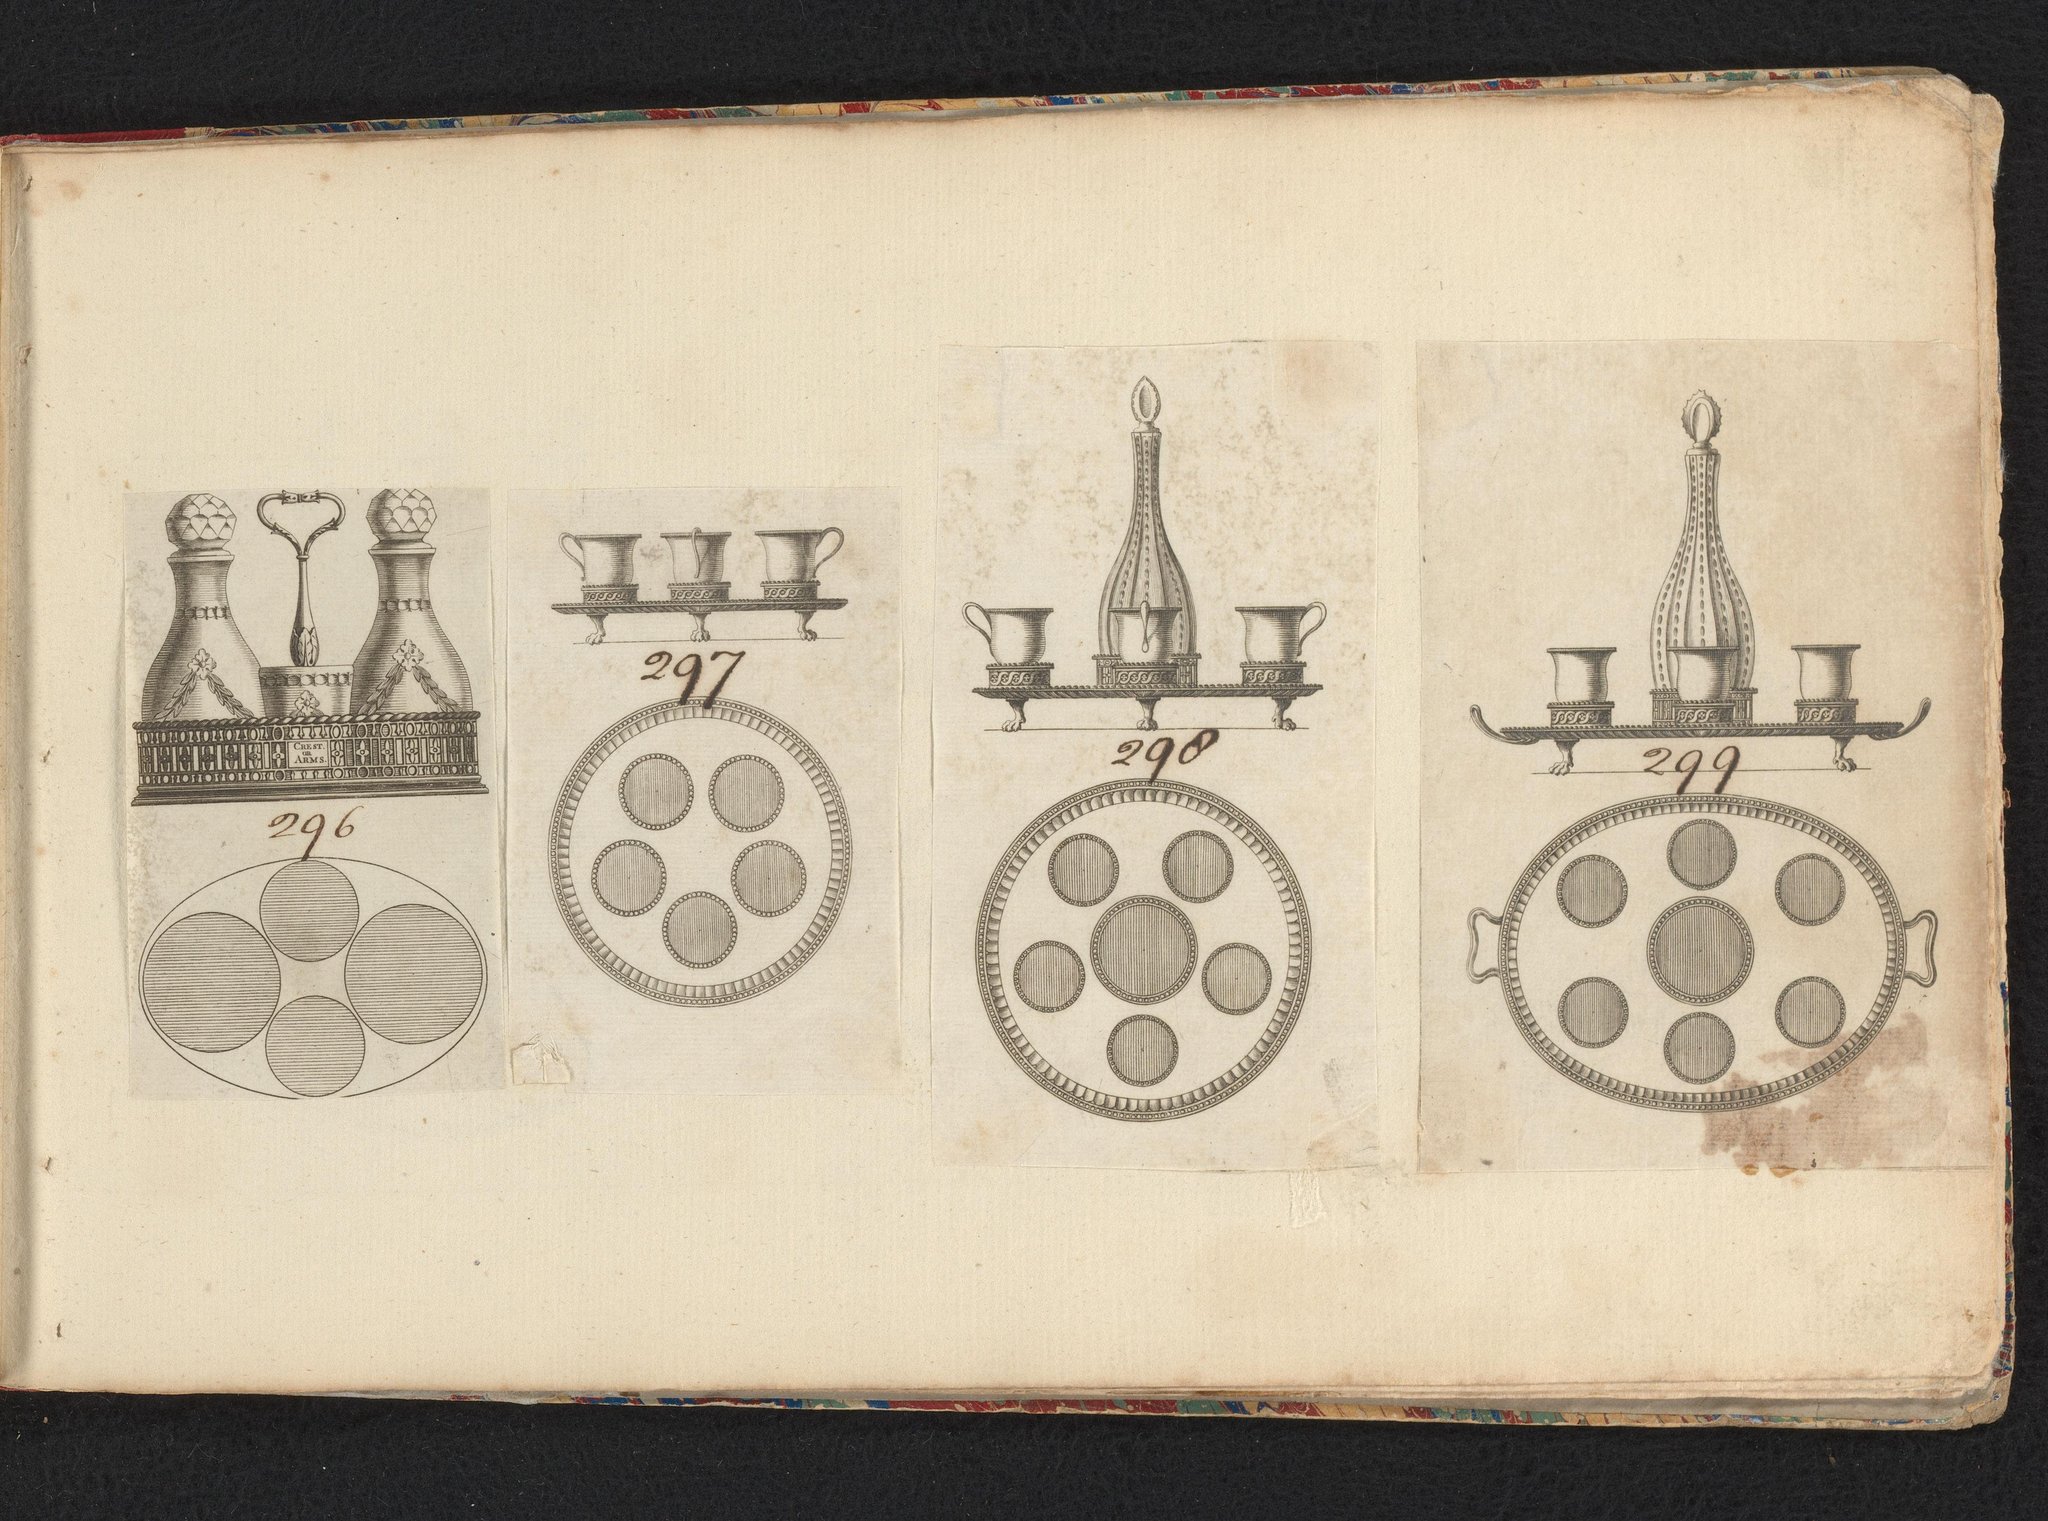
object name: album leaf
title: Ontwerpen voor olie- en azijnstellen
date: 1784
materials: paper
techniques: engraving, etching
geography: england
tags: spice-box, table-ware, oil, vinegar, sauces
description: Blad met vier ingeplakte bladen met ontwerpen voor olie- en azijnstellen en mosterdpotten. Met handgeschreven nrs. 296-299. Onderdeel van een catalogus met assortiment modellen van Sheffield verzilverd vaatwerk (pleet) door Matthew Boulton.